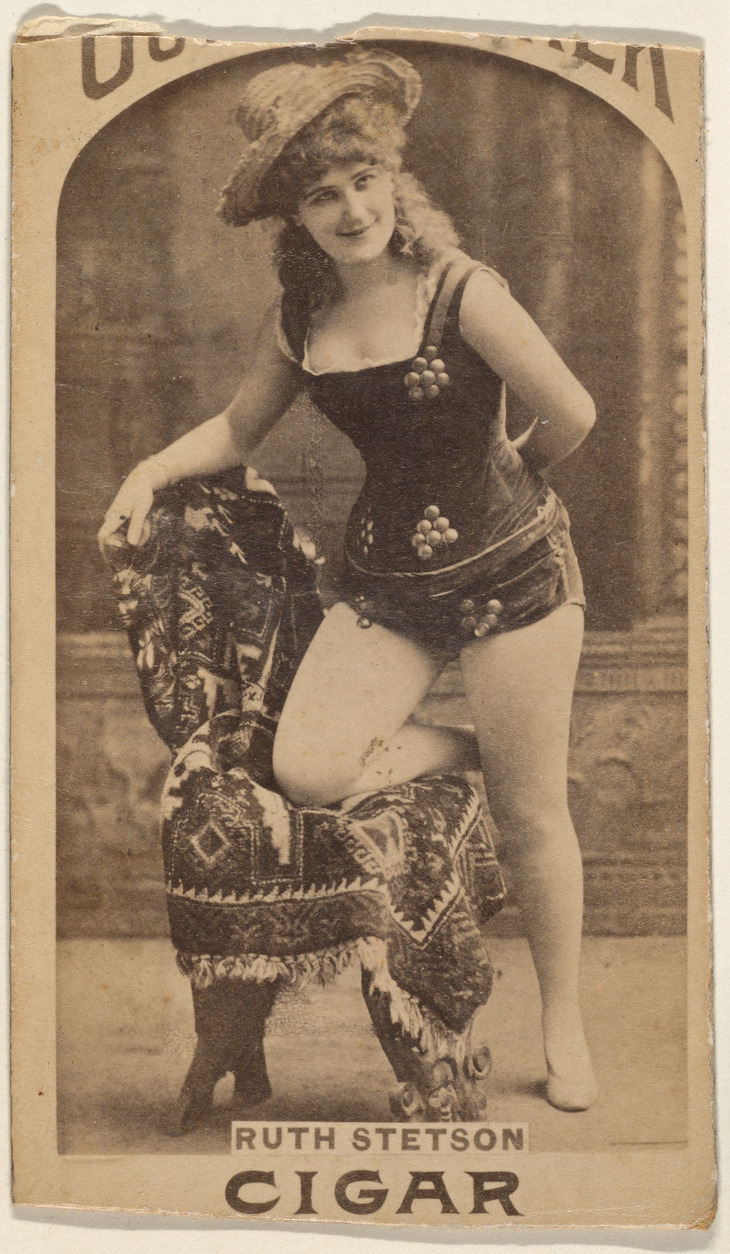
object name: photograph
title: Ruth Stetson, from the Actresses series (N665) promoting Our Knocker Cigars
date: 1888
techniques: albumen silver print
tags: portraits,women,actresses